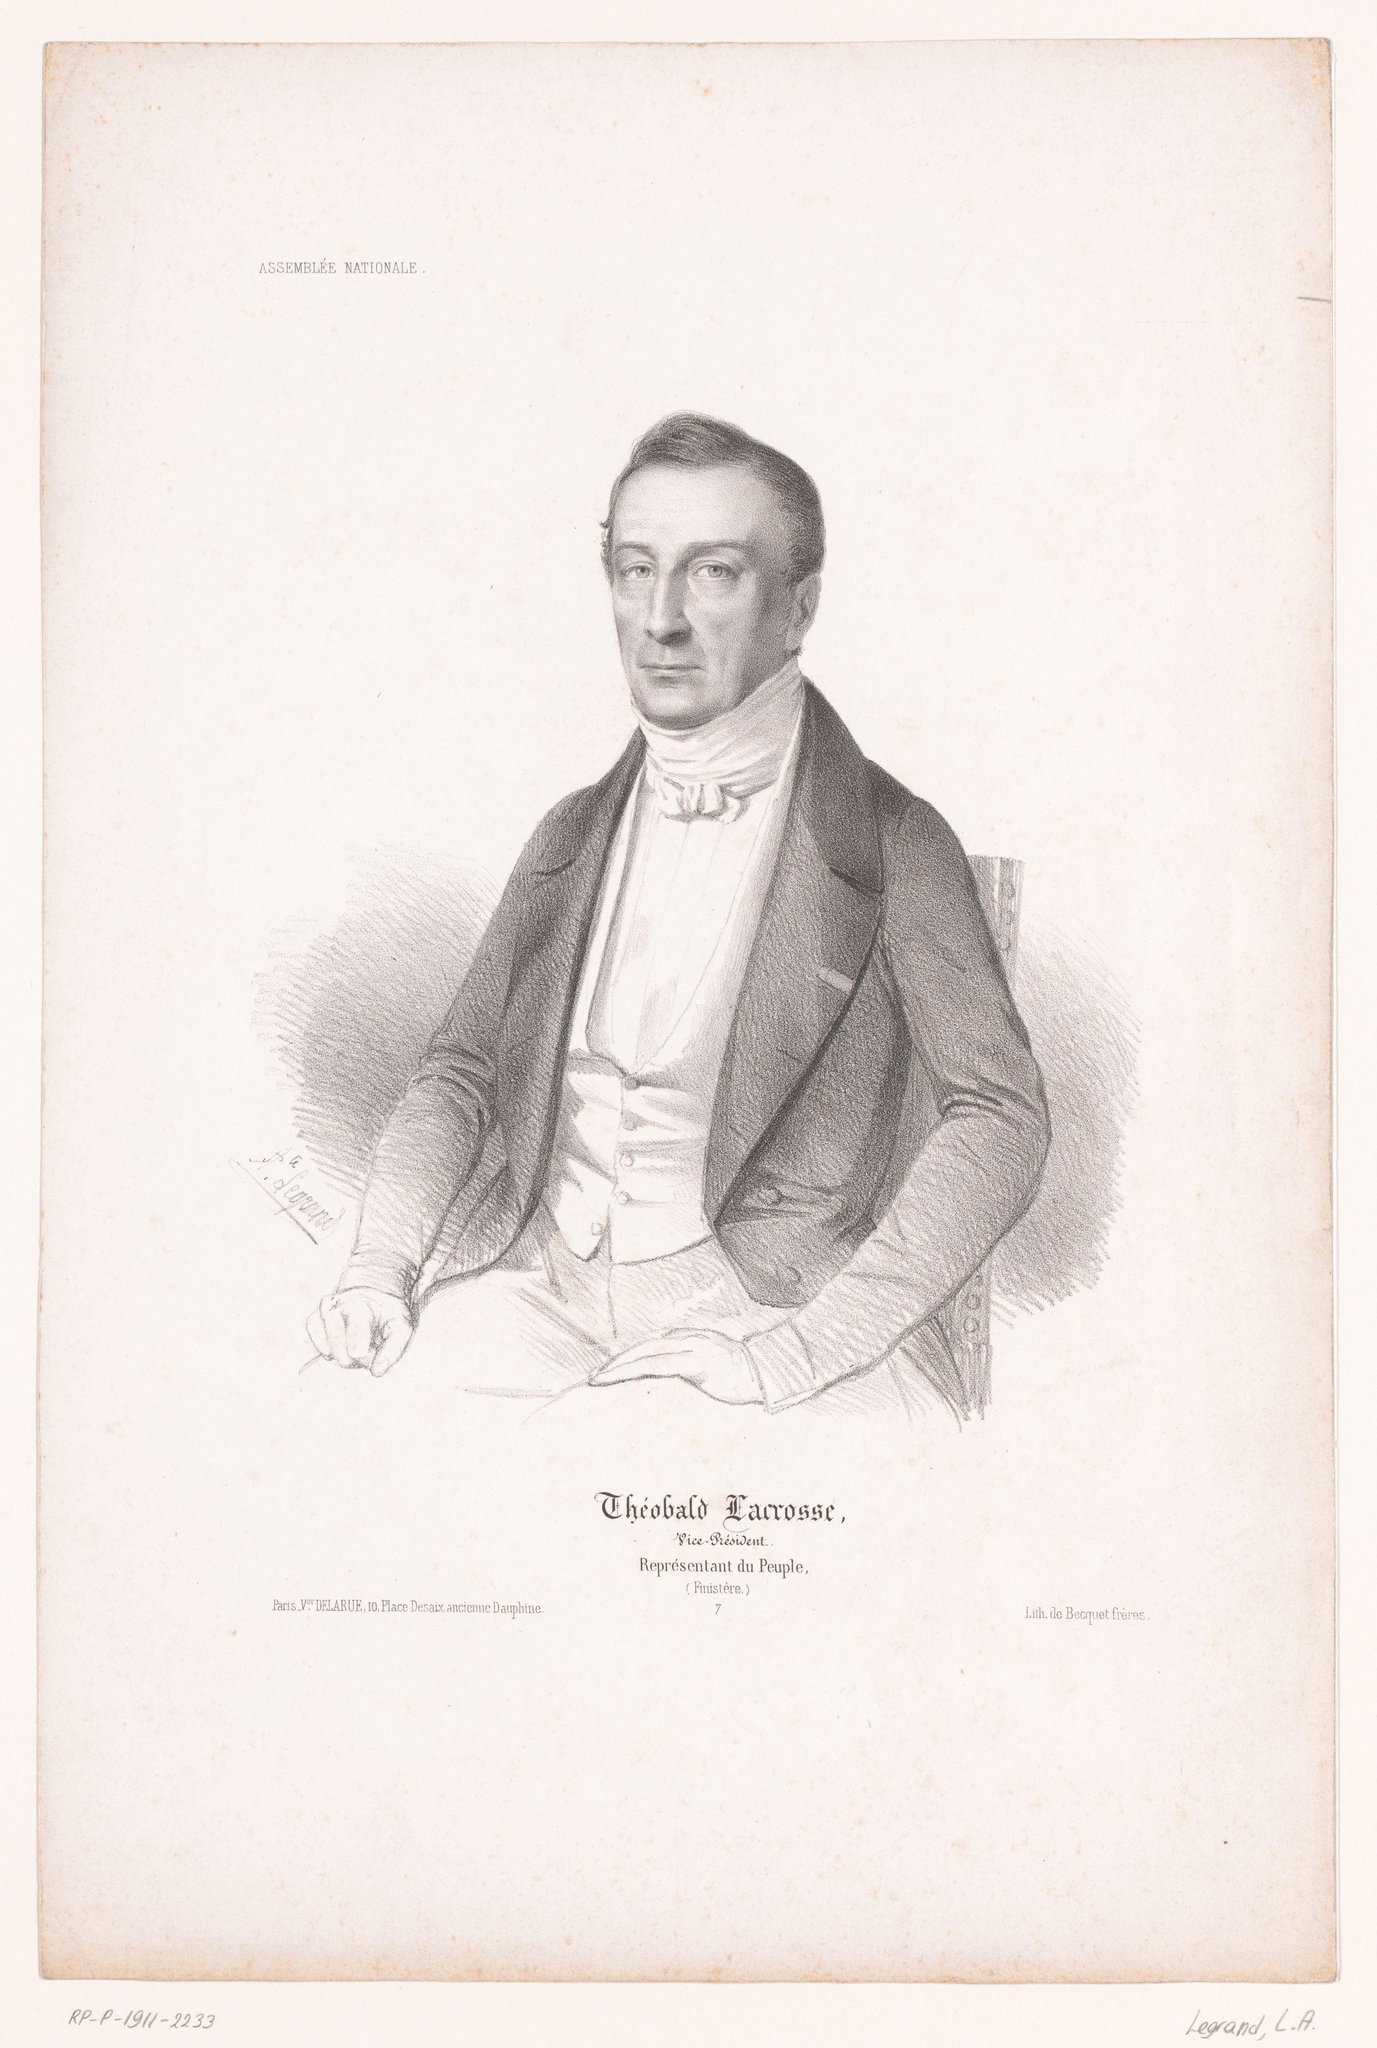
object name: print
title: Théobald Lacrosse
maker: auguste legrand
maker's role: draughtsman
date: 1848-1849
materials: paper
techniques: lithograph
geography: paris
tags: paris, politician, historical persons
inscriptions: collector's mark: Lugt 2228a